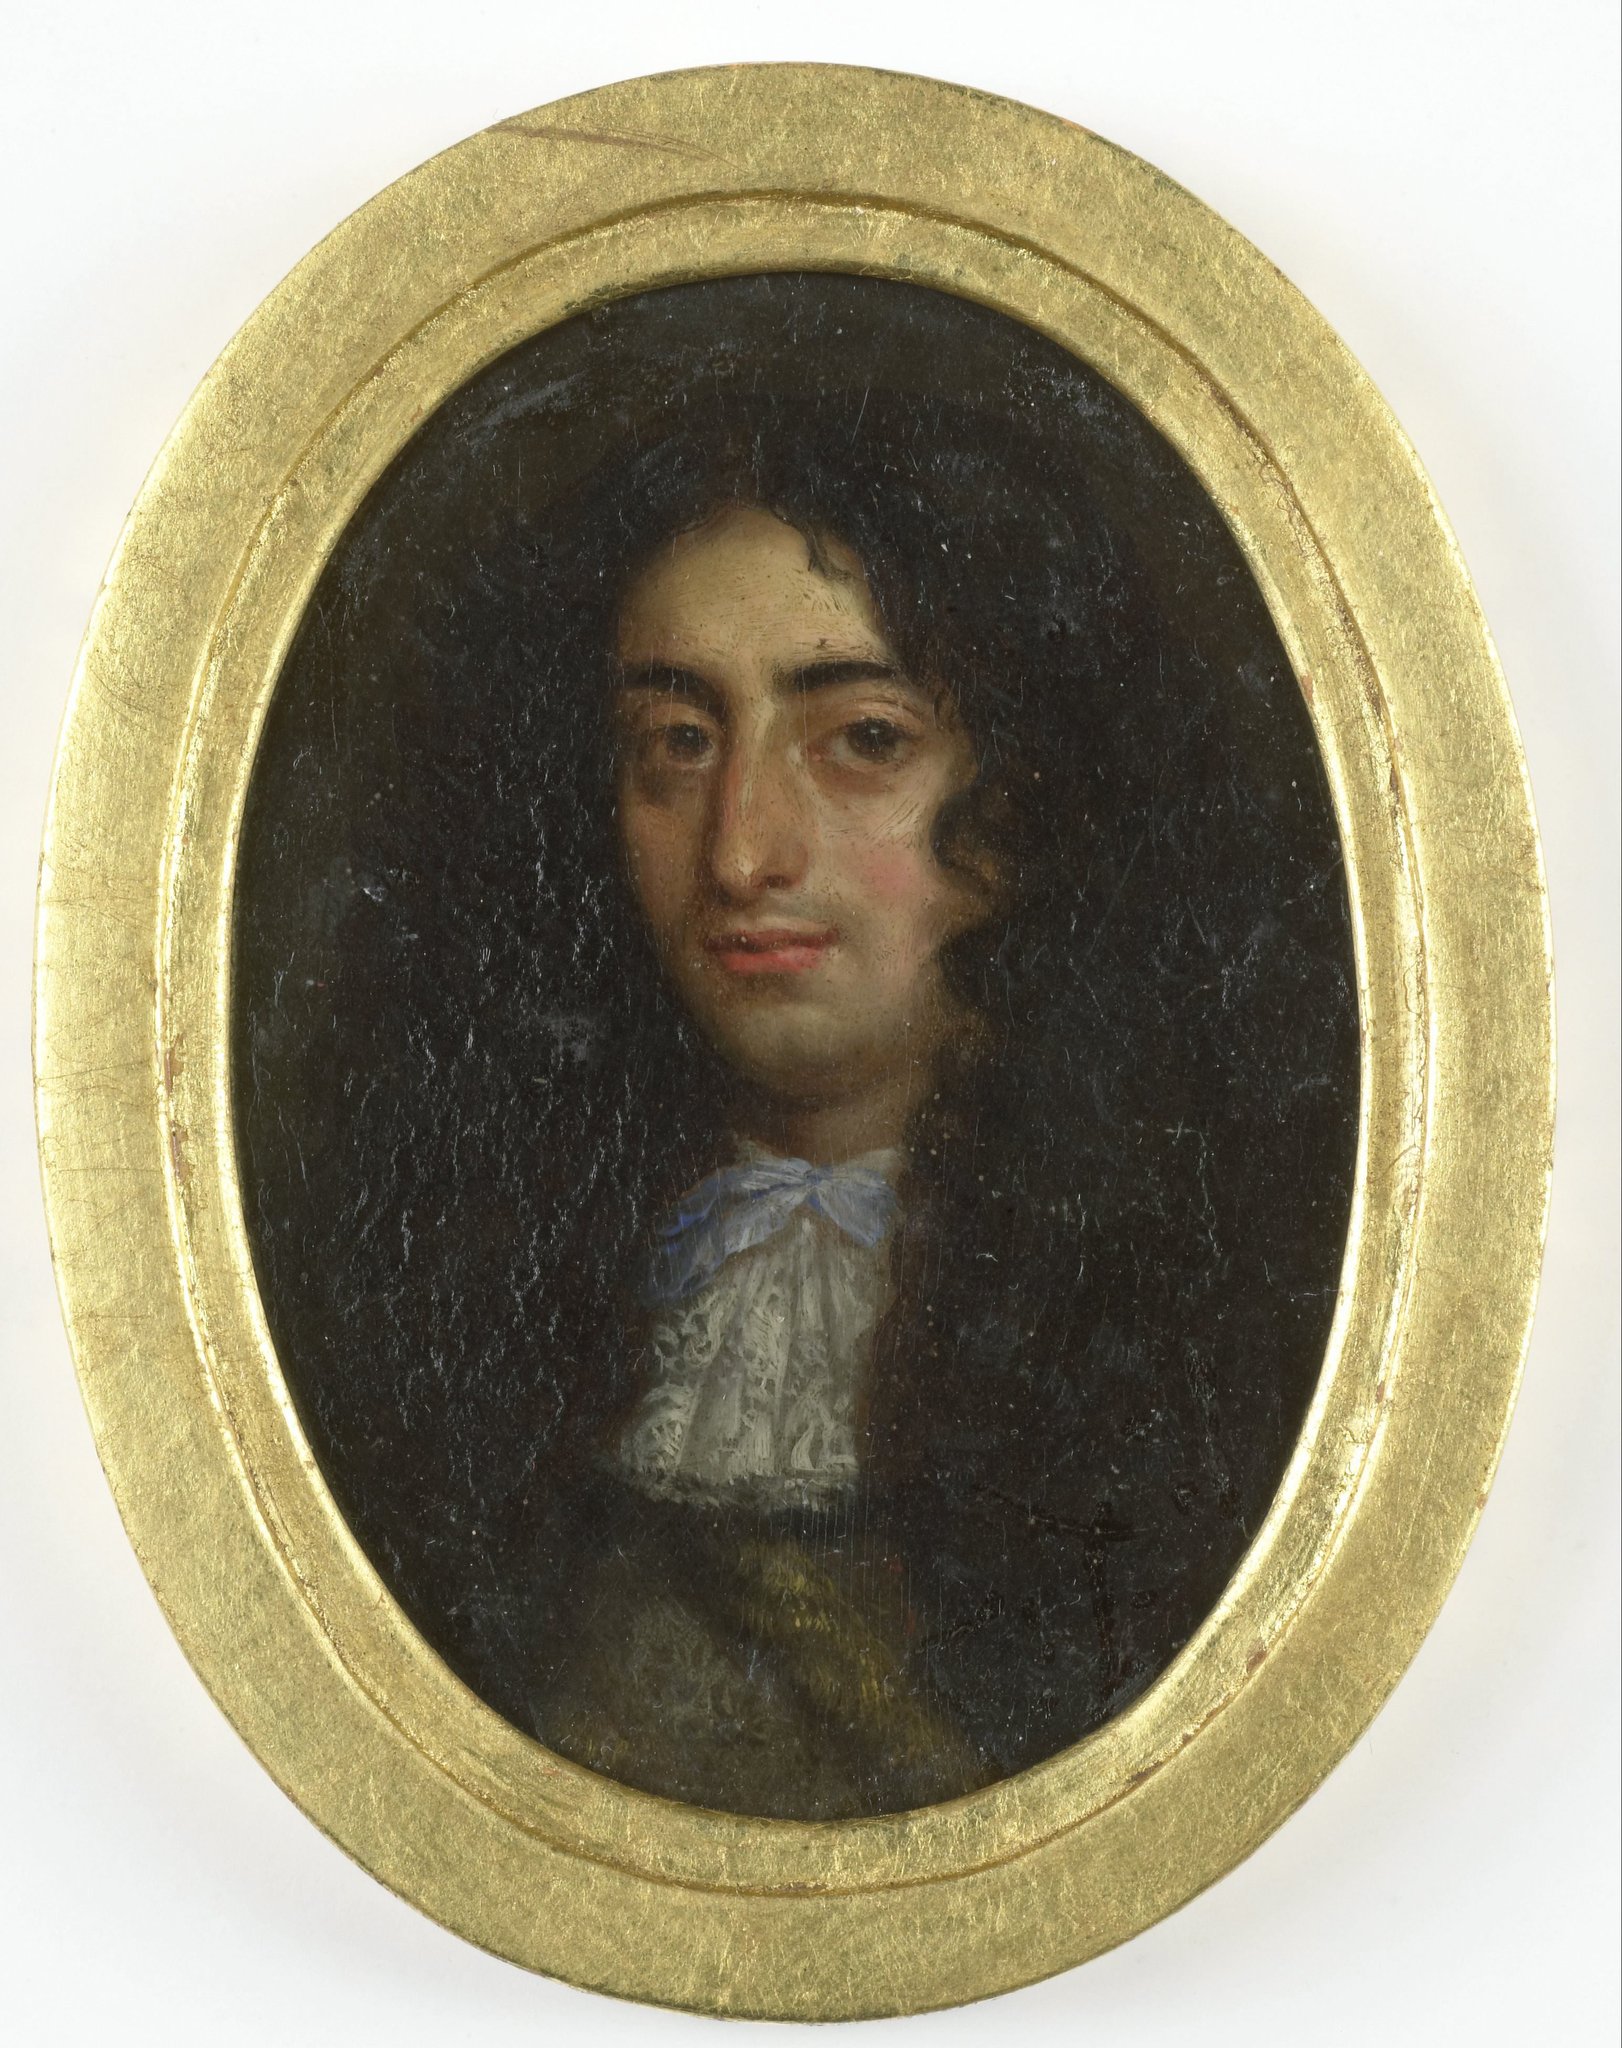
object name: painting, miniature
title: Portret van een officier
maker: Anonymous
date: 1675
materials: copper, oil, wood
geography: northern netherlands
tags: historical persons not known by name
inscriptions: inscription: ‘Eglon v Neer?’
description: Portret van een officier. Buste, iets naar links, aanziend. Onderdeel van de collectie portretminiaturen.